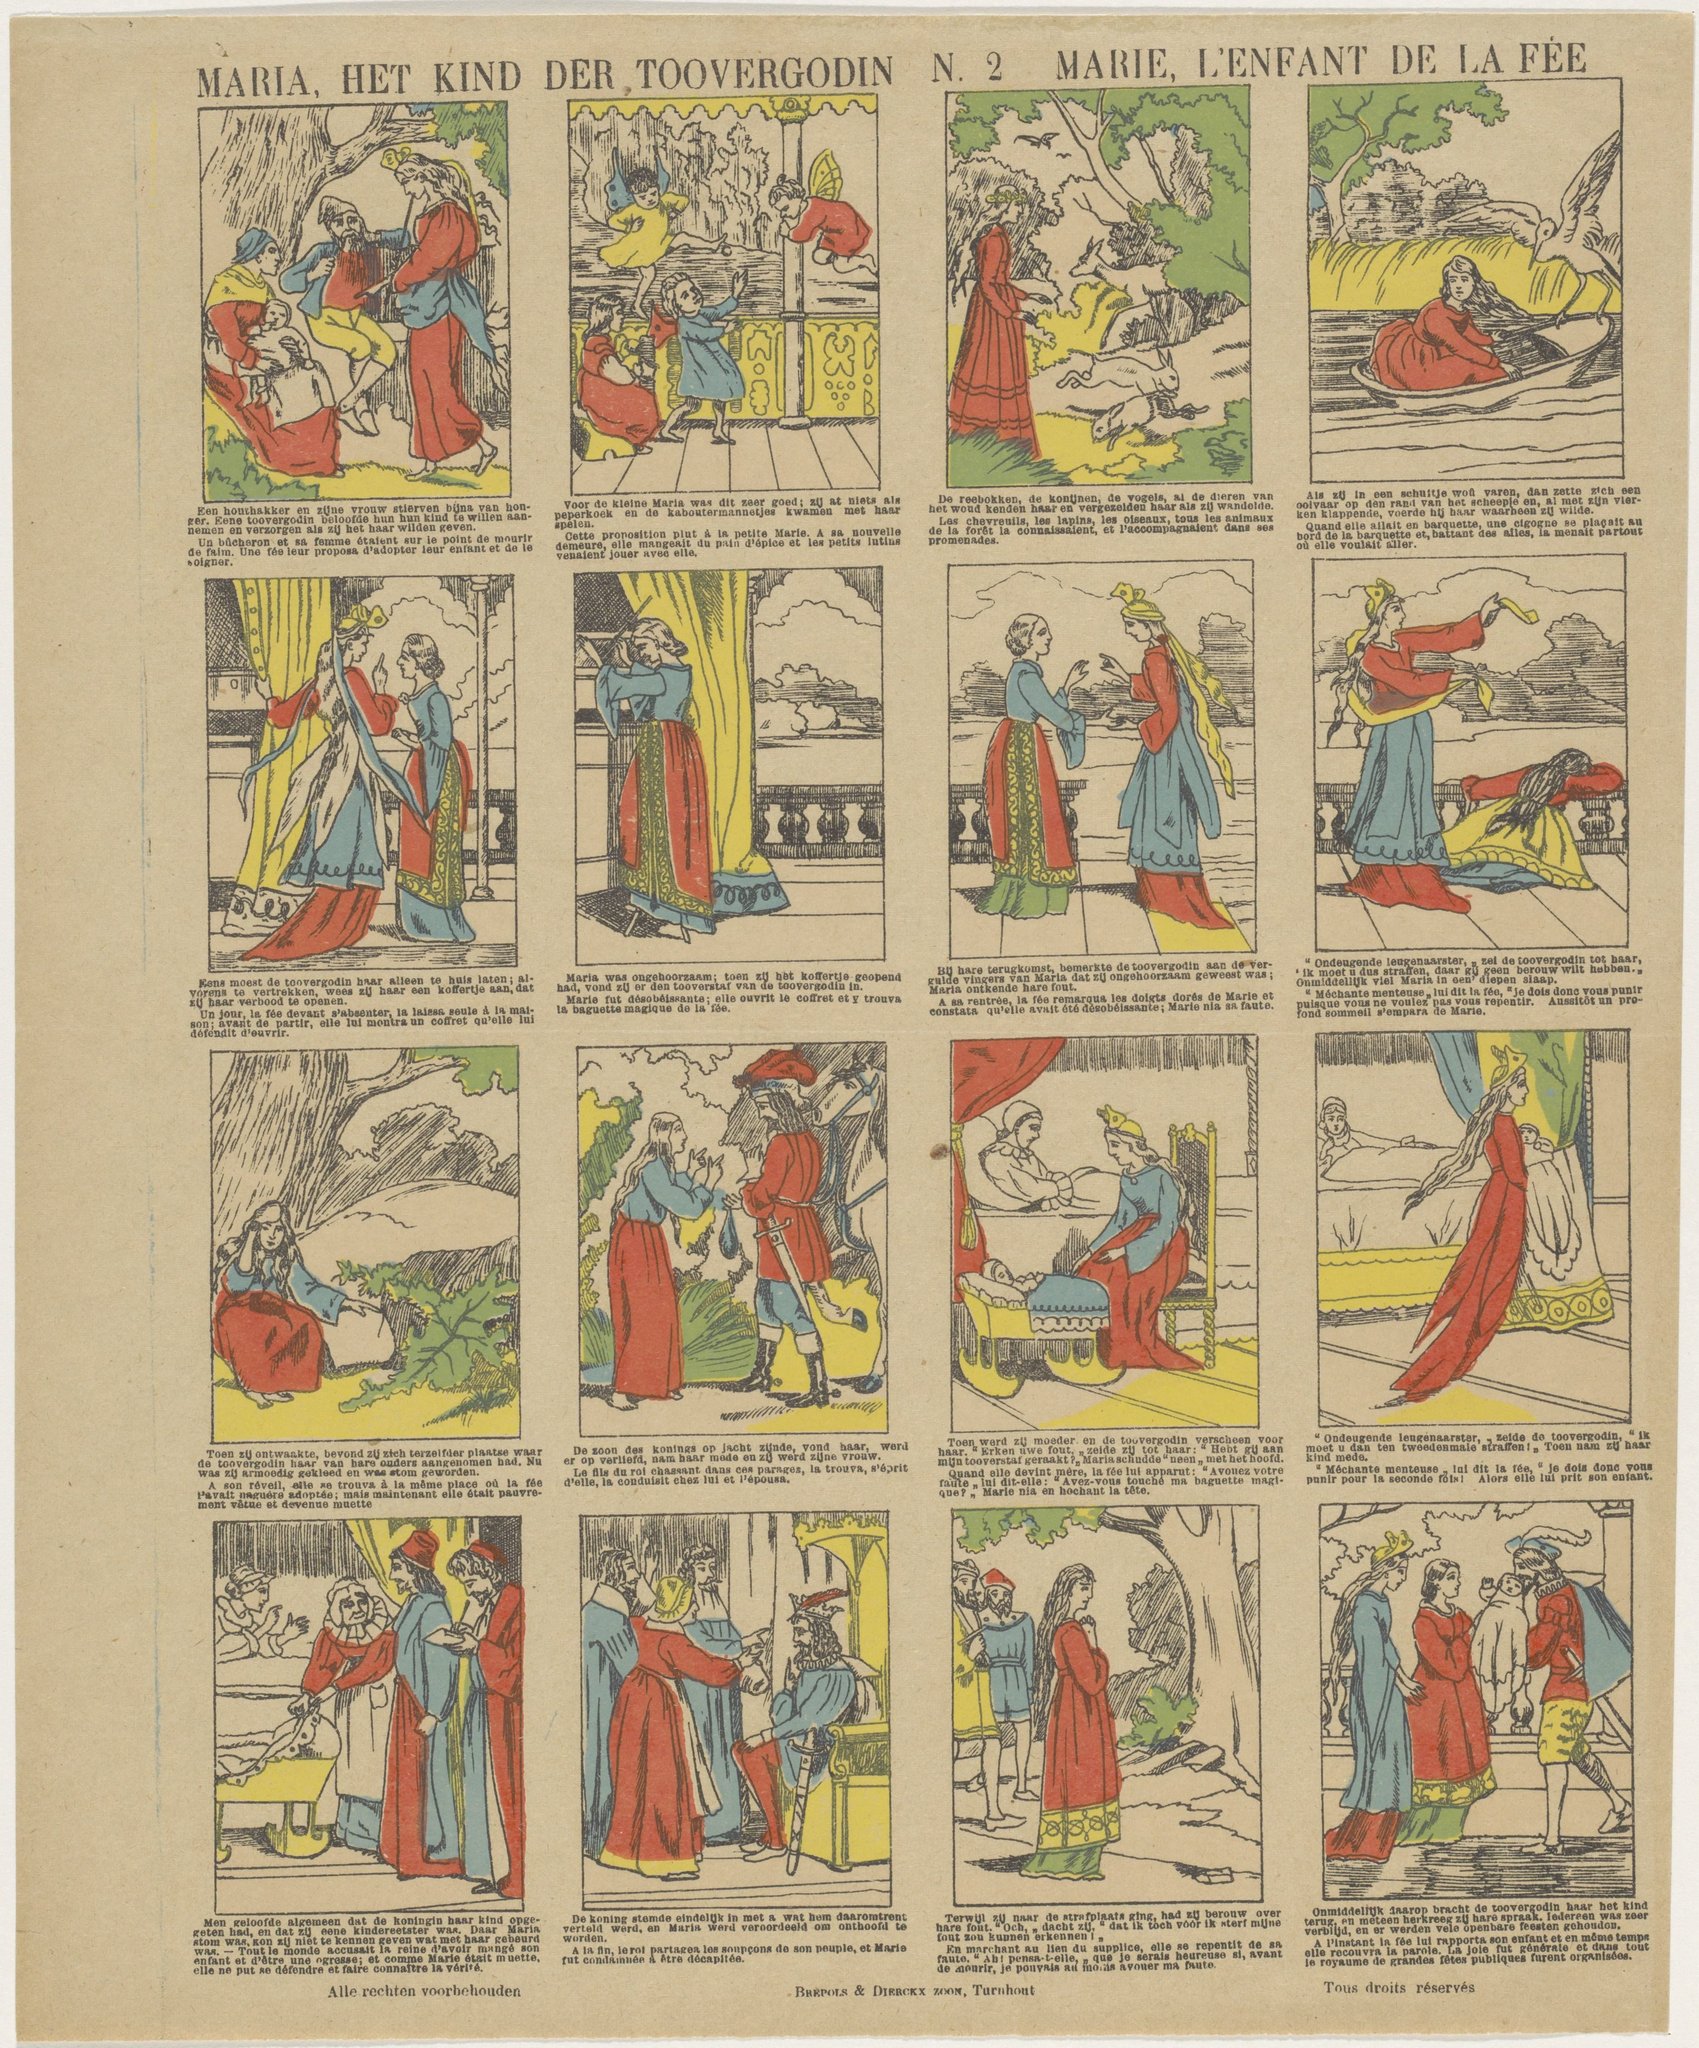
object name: print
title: Maria, het kind der toovergodin / Marie, l'enfant de la fée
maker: Anonymous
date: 1833-1911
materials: paper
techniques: lithograph, letterpress printing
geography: turnhout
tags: tales and fairy tales, representations ~ goddesses, demi-goddesses, heroines, etc. (non-christian religions)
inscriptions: octrooivermelding, gedrukt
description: Blad met 16 voorstellingen uit het sprookje van Maria, het kind van een tovergodin. Onder elke afbeelding een onderschrift in het Nederlands en in het Frans. Genummerd midden boven: N. 2.